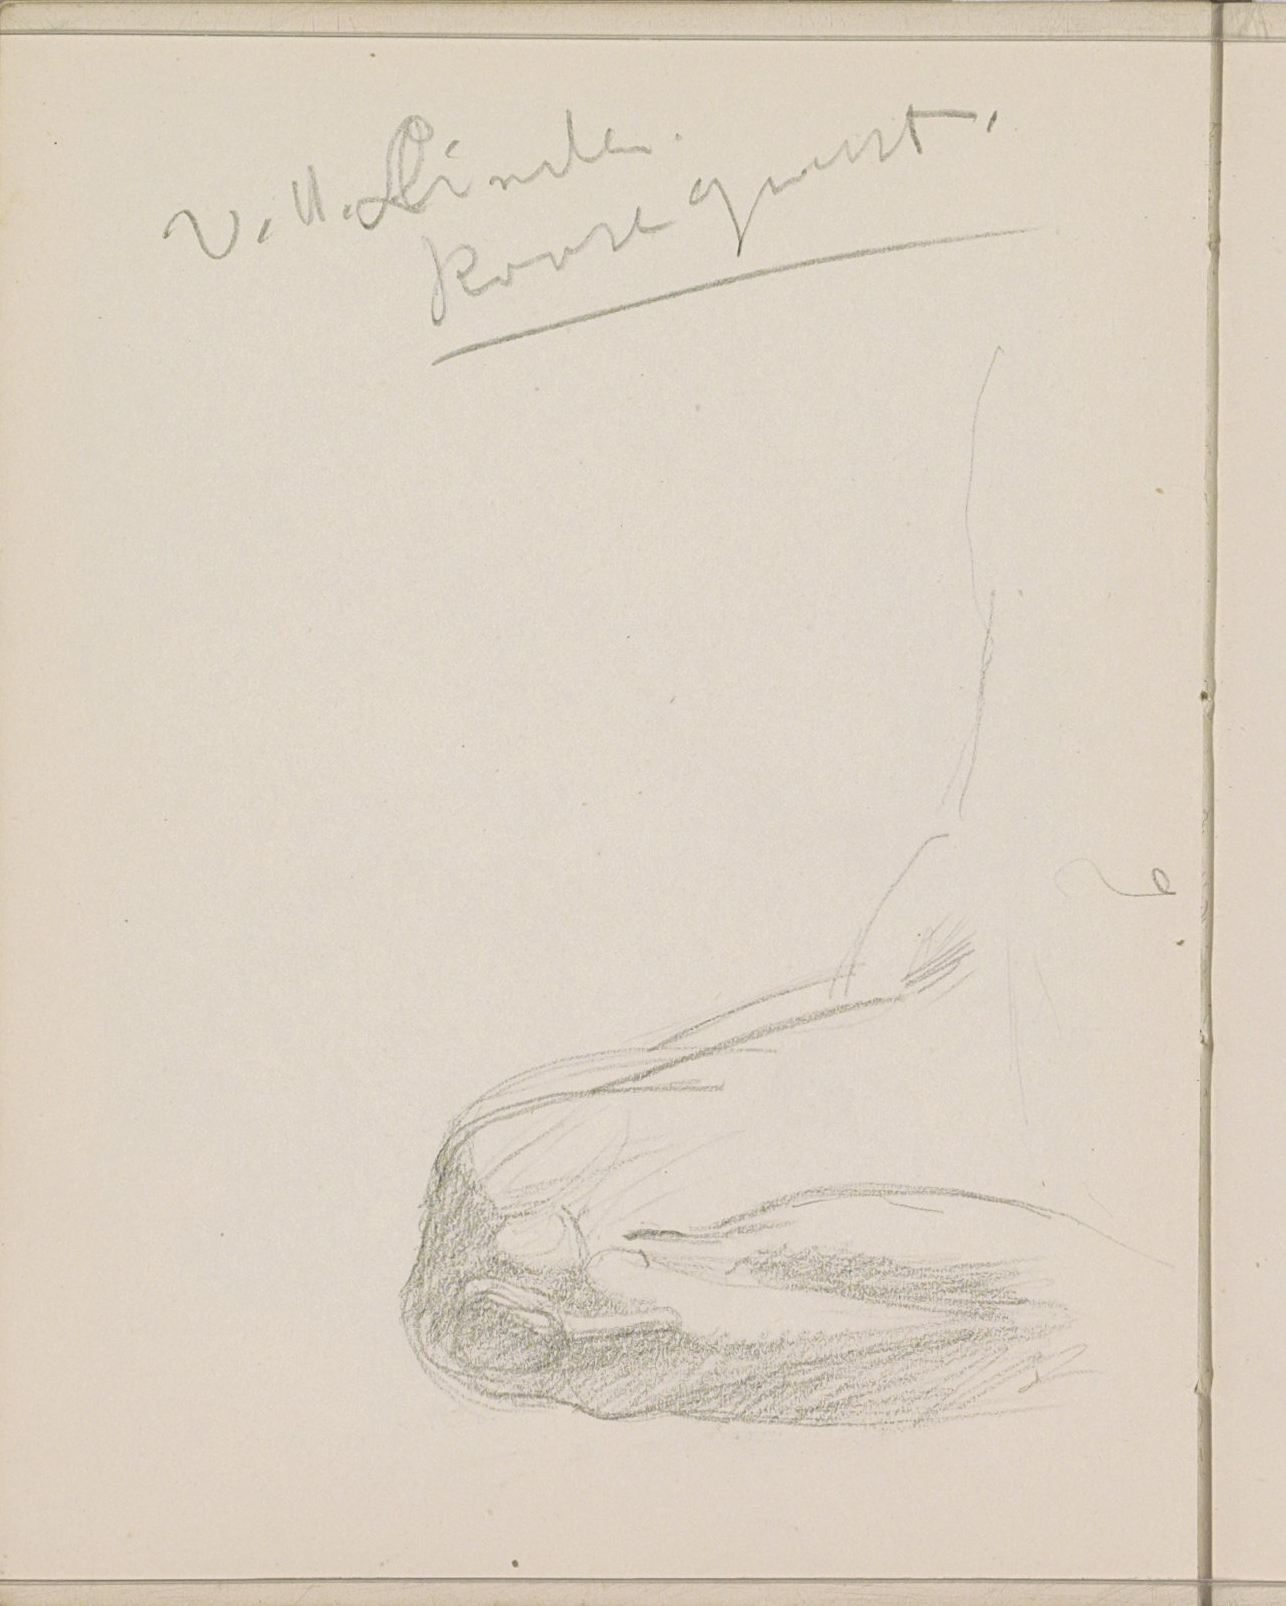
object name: sketchbook leaf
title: Studie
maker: reijer stolk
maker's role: draughtsman, print maker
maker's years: 1896-1945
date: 1916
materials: paper, pencil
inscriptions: annotation: ‘vi[...]di[...]de/ Roose g[...]rt’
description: Mogelijk spieren. Blad 55 verso uit een schetsboek met 72 bladen.